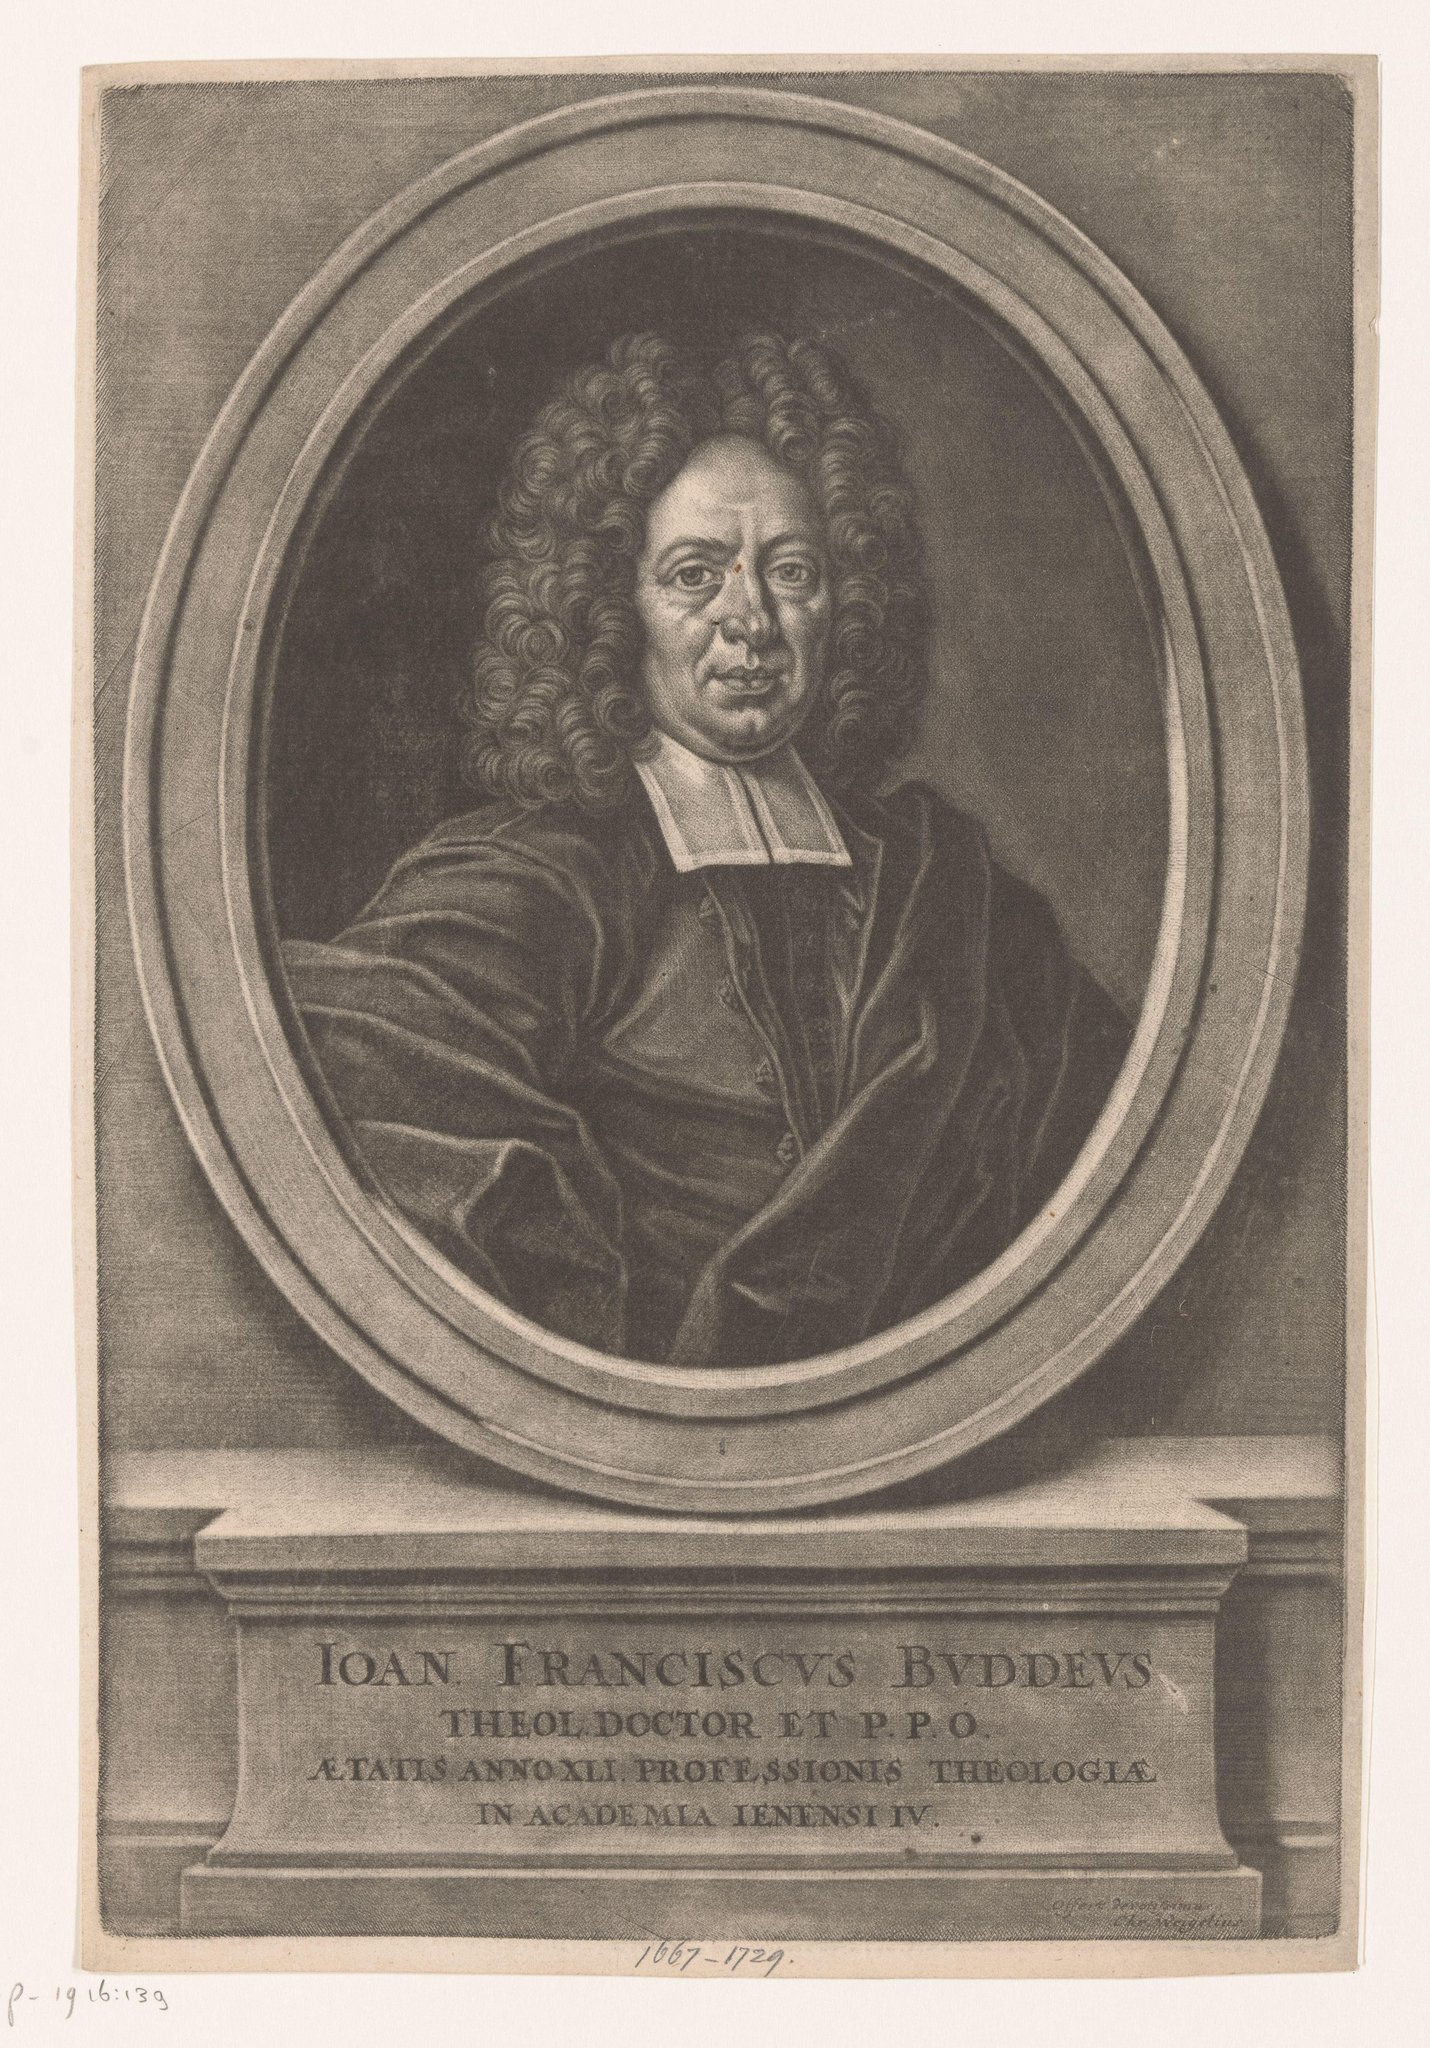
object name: print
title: Portret van Johann Franz Buddeus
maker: christoph weigel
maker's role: goldsmith, print maker, publisher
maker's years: 1654-1725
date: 1677-1725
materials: paper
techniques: mezzotint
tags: historical persons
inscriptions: inscription, collector's mark: Lugt 2228